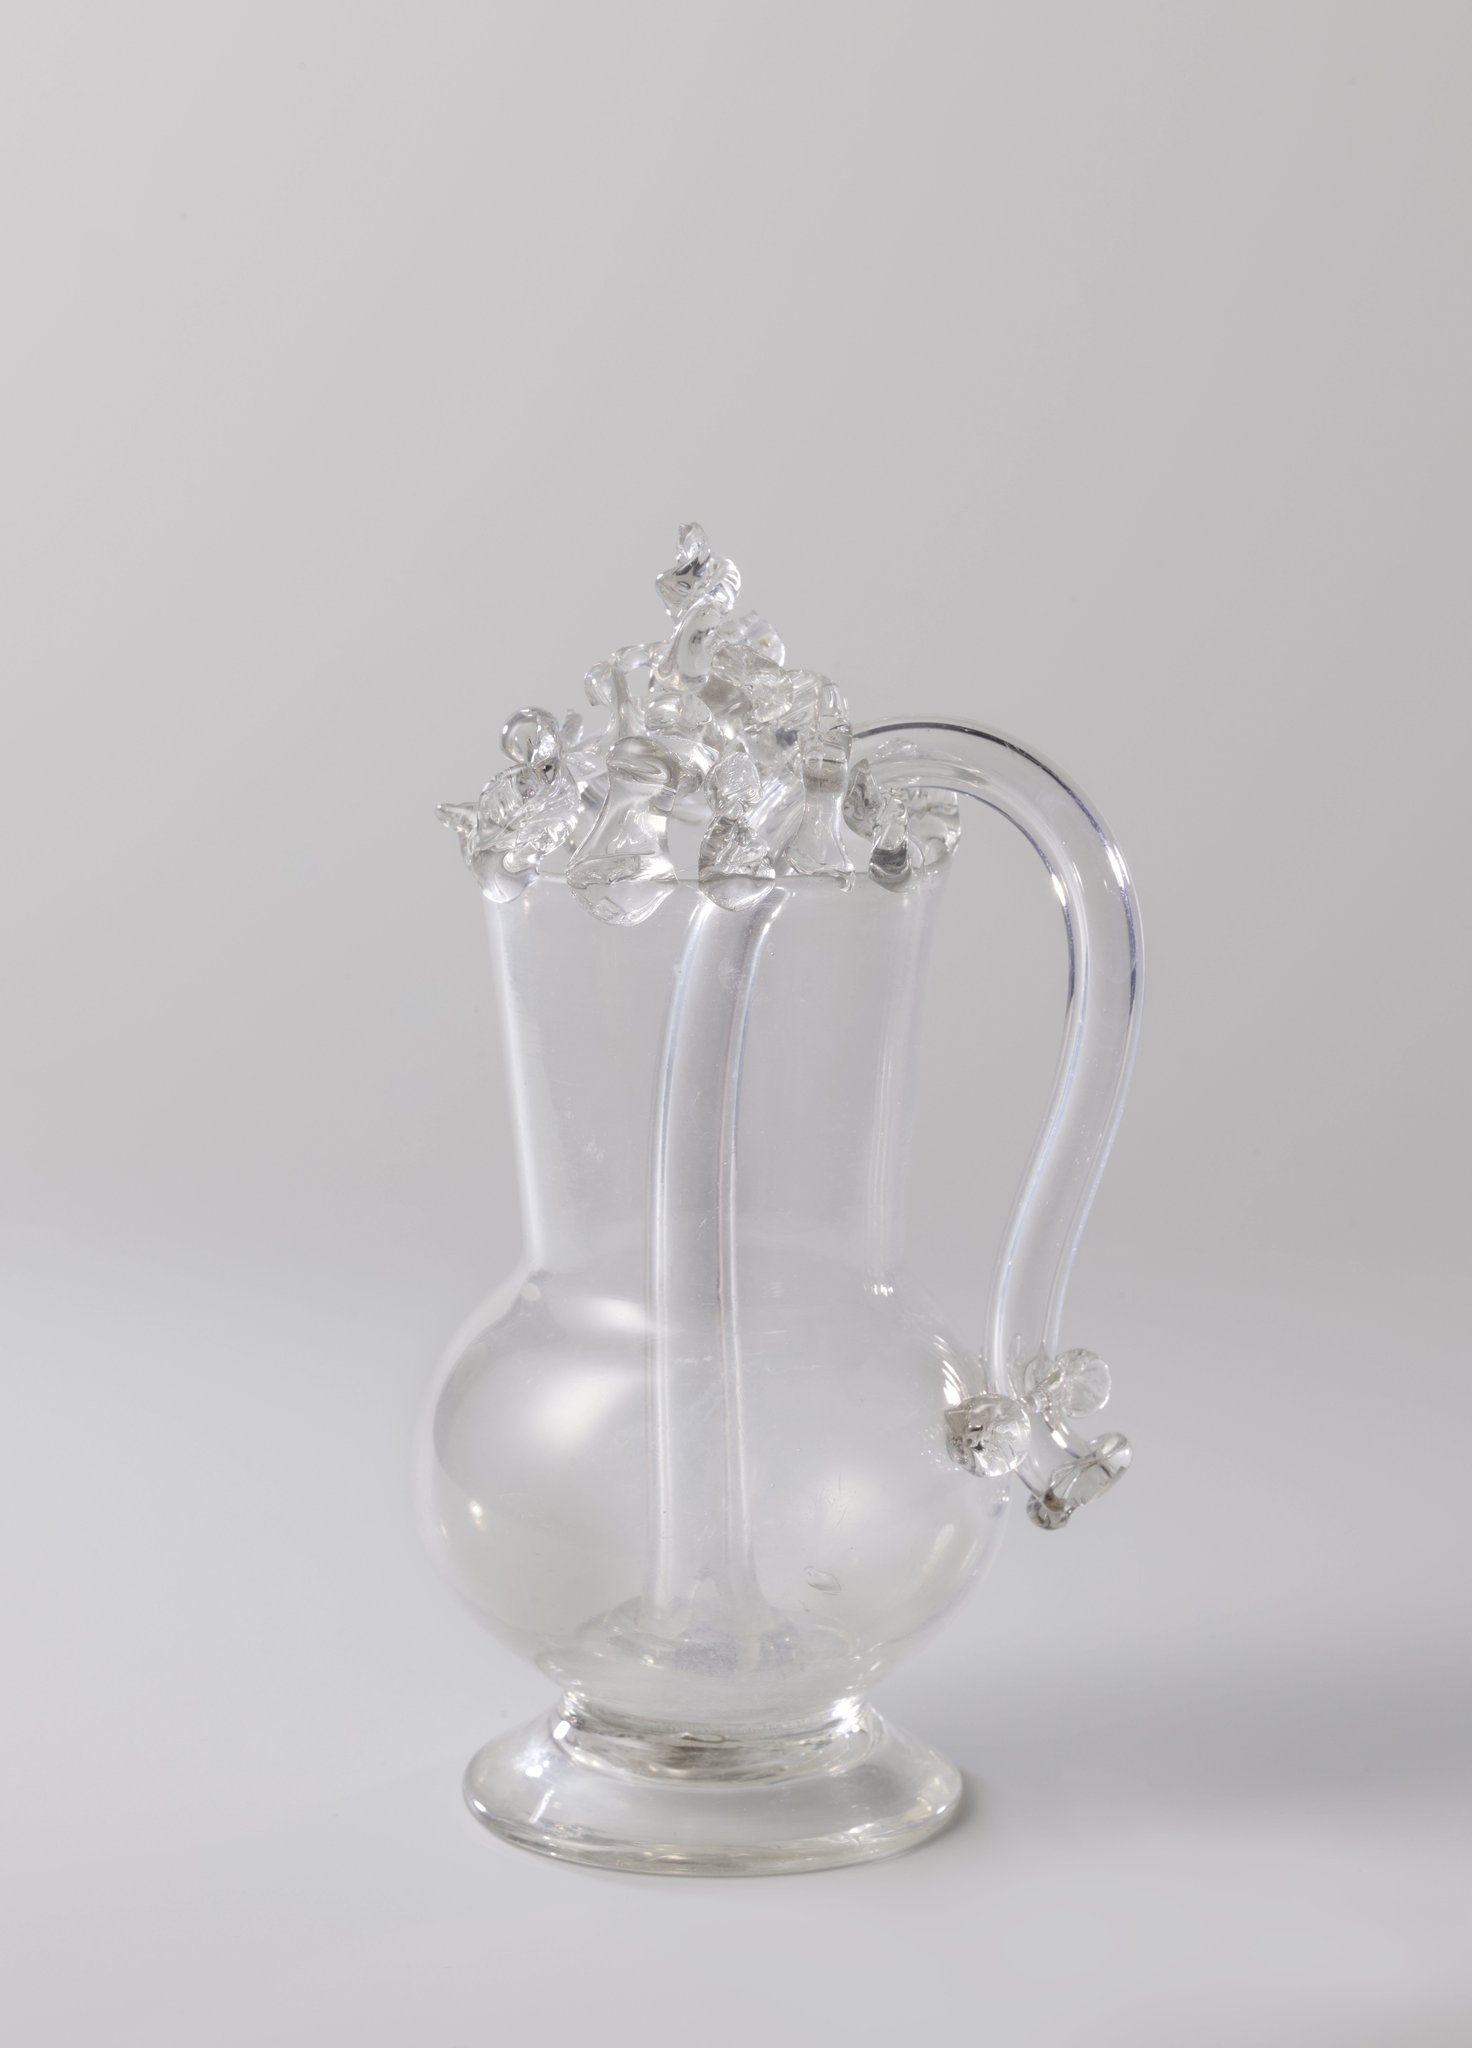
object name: trick glass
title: Sifonglas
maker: Anonymous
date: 1700-1800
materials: glass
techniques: glassblowing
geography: bohemia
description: Sifonglas met lage, licht conische voet. Bolvormig lichaam, overgaand in een hoge, wijde hals. De bovenzijde afgesloten met vijf geknepen, stervormig geplaatste banden. Het oor bestaat uit een gebogen buis, die in open verbinding staat met het lichaam.